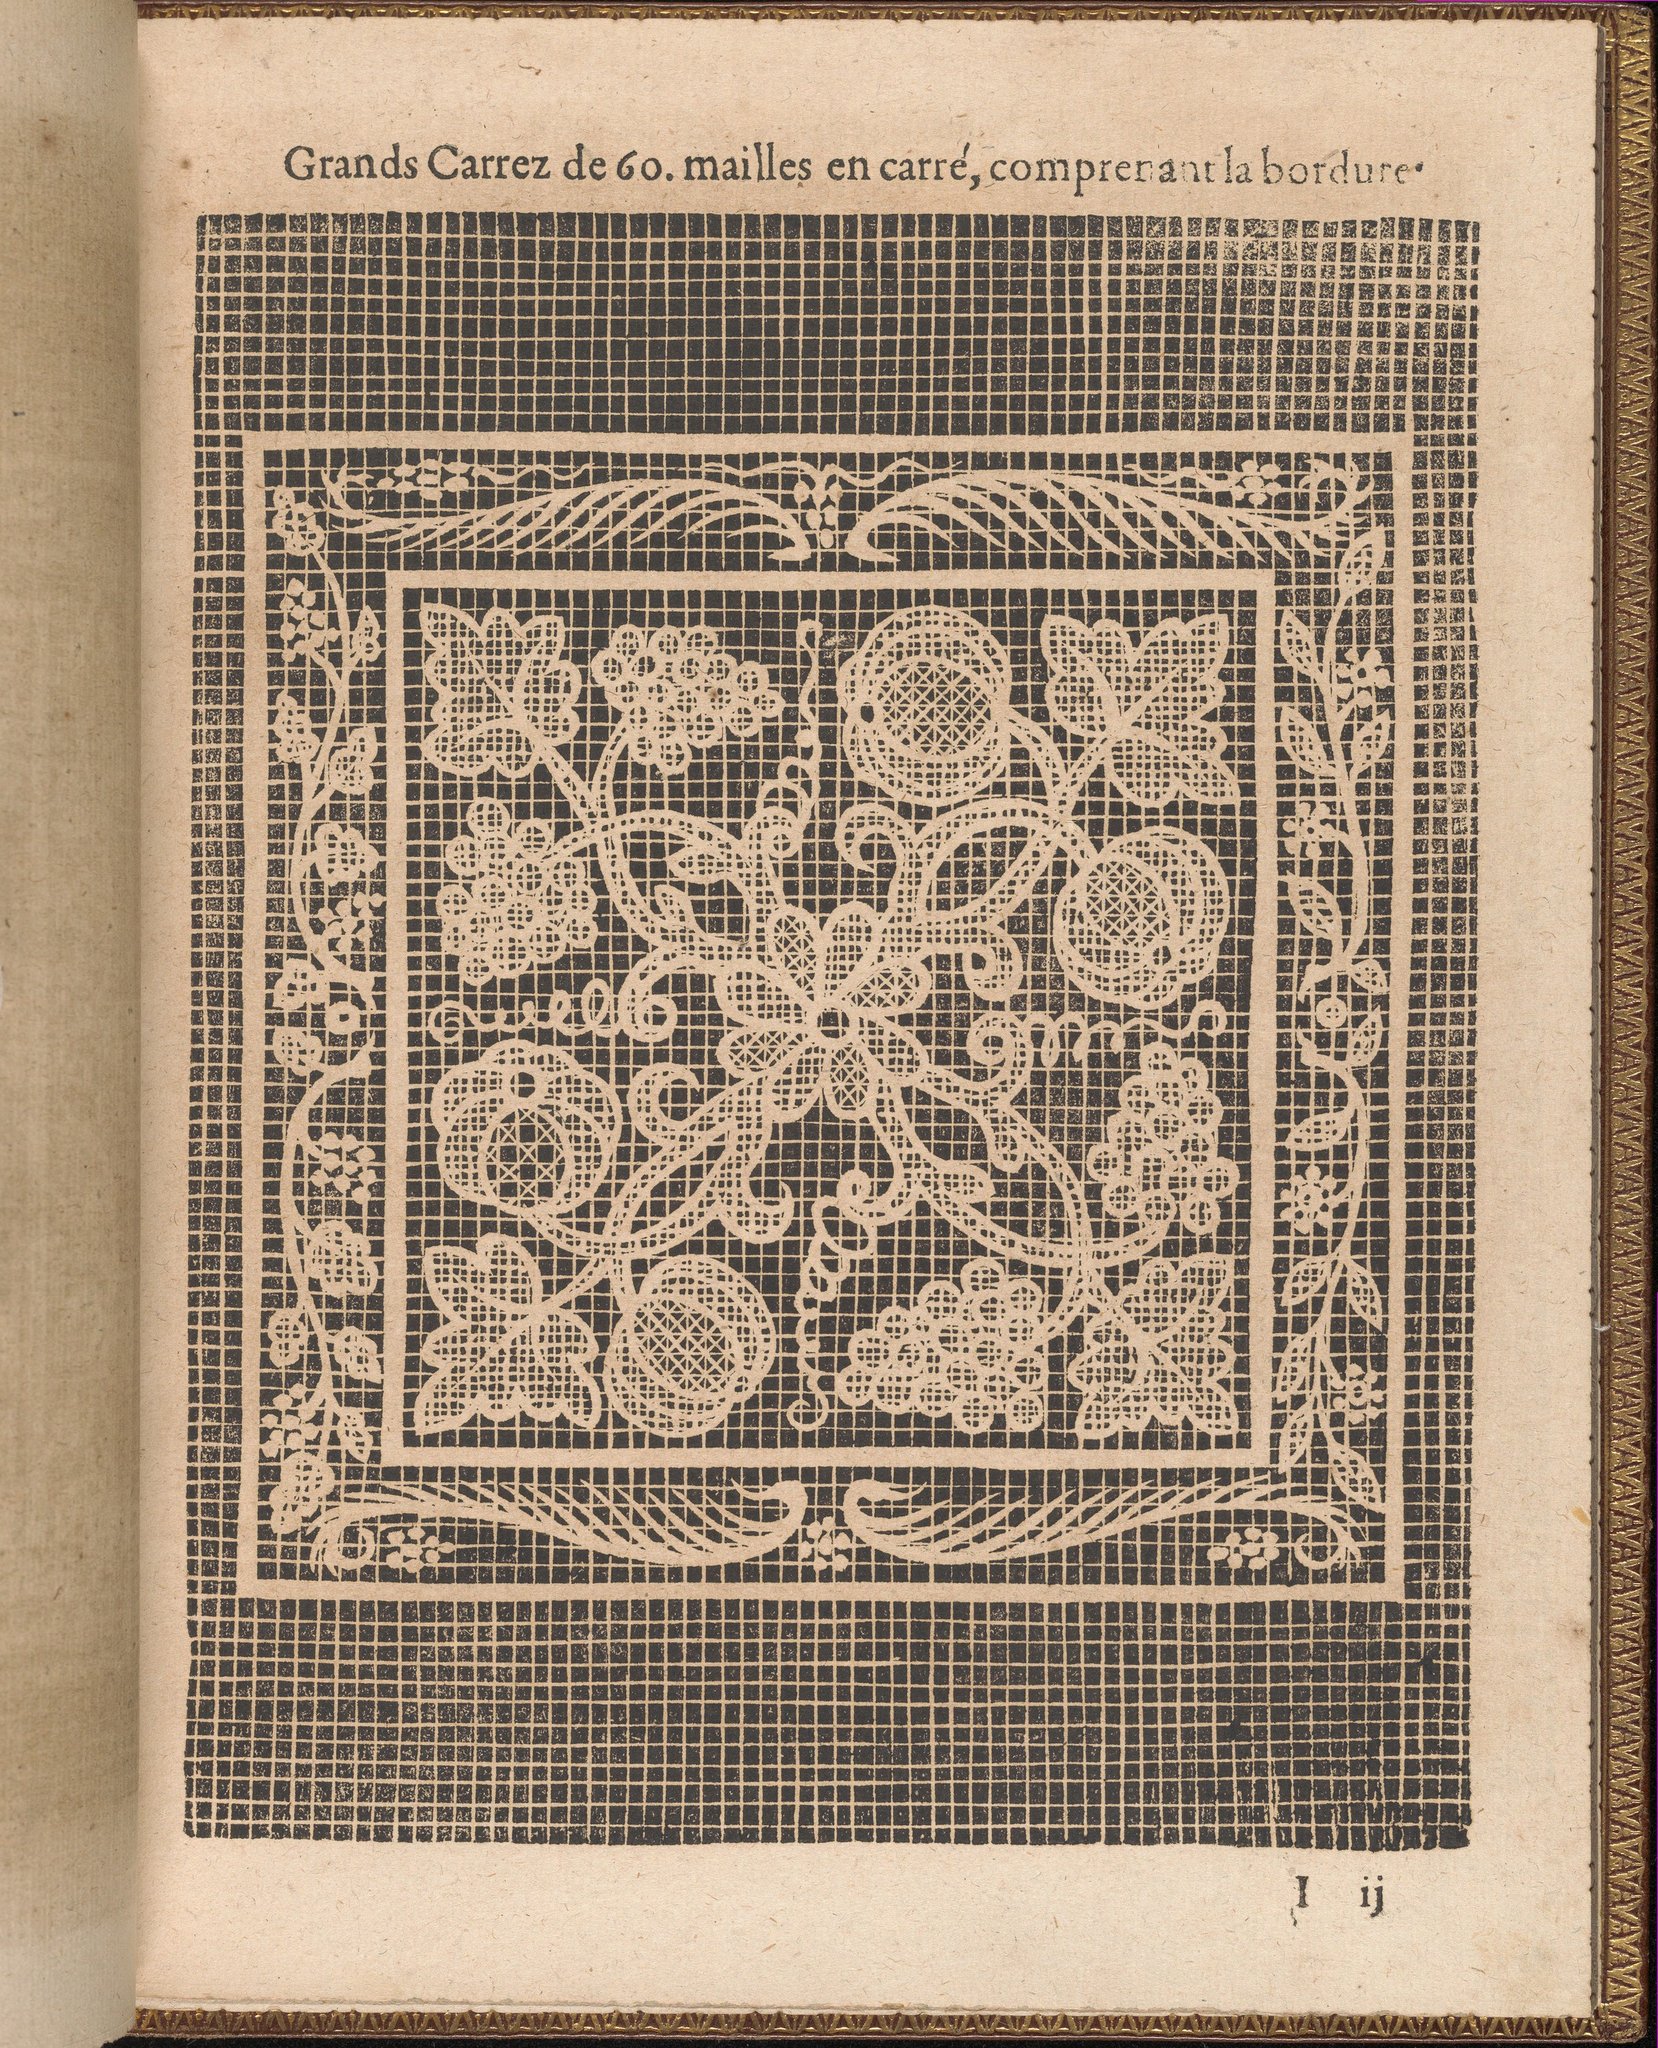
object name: book print ornament architecture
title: La Pratique de l'Aiguille, page 33 (recto)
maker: matthias mignerak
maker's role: author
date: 1605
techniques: woodcut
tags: ornament,fruit